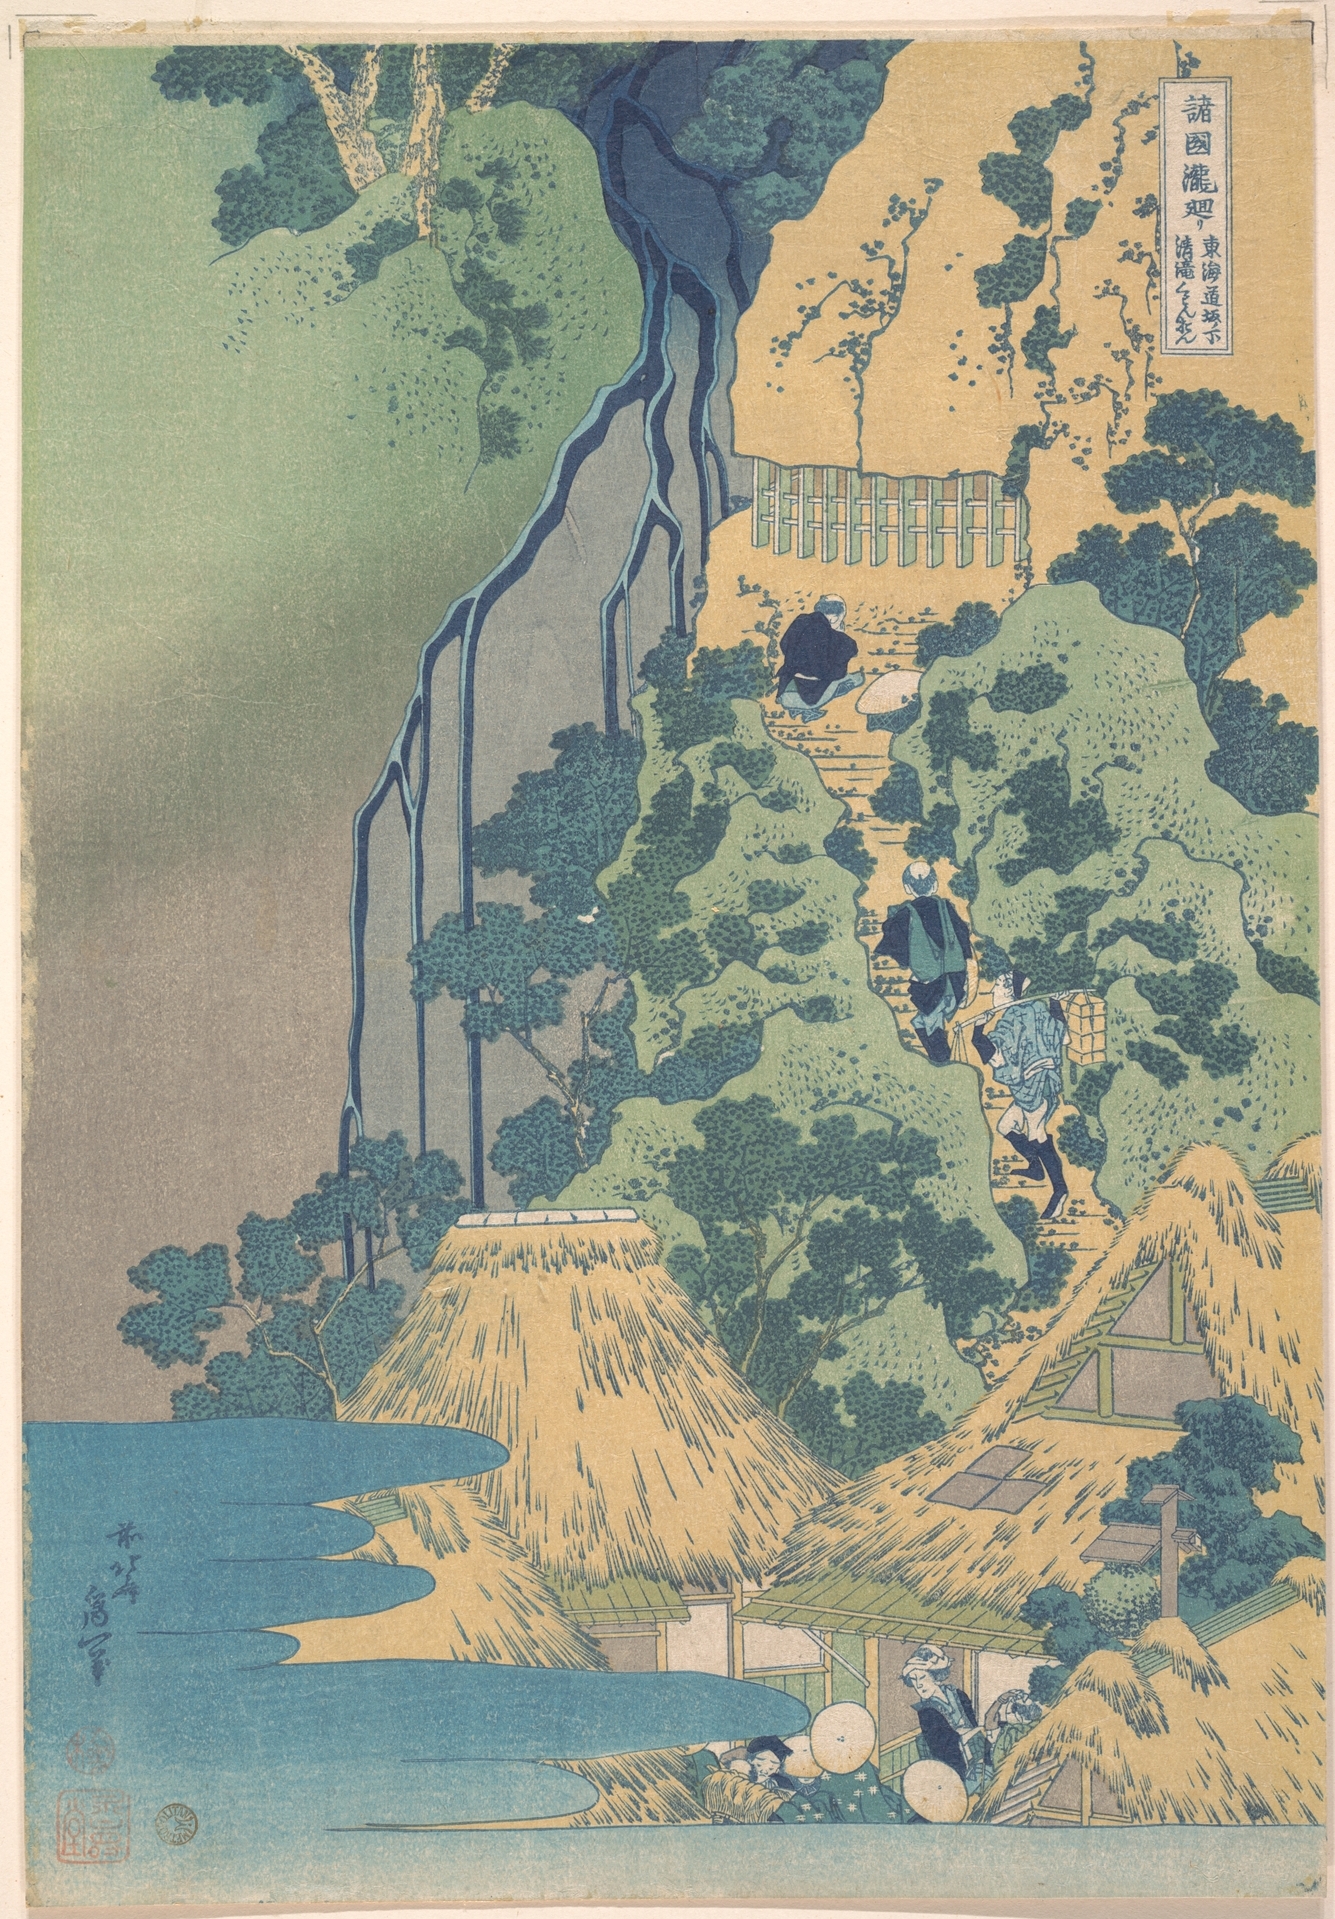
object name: woodblock print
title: Kiyotaki Kannon Waterfall at Sakanoshita on the Tōkaidō (Tōkaidō Sakanoshita Kiyotaki kannon), from the series A Tour of Waterfalls in Various Provinces (Shokoku taki meguri)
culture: japanese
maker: katsushika hokusai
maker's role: artist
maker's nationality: japanese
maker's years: 1760-1849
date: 1832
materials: ink, paper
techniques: woodblock print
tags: human figures,houses,waterfalls,trees